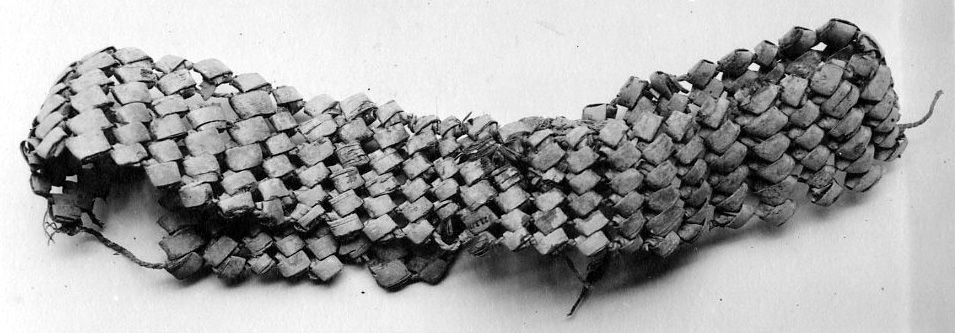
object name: girdle, hip belt, fiber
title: Girdle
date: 1479-1458 BCE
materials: leaf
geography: egypt